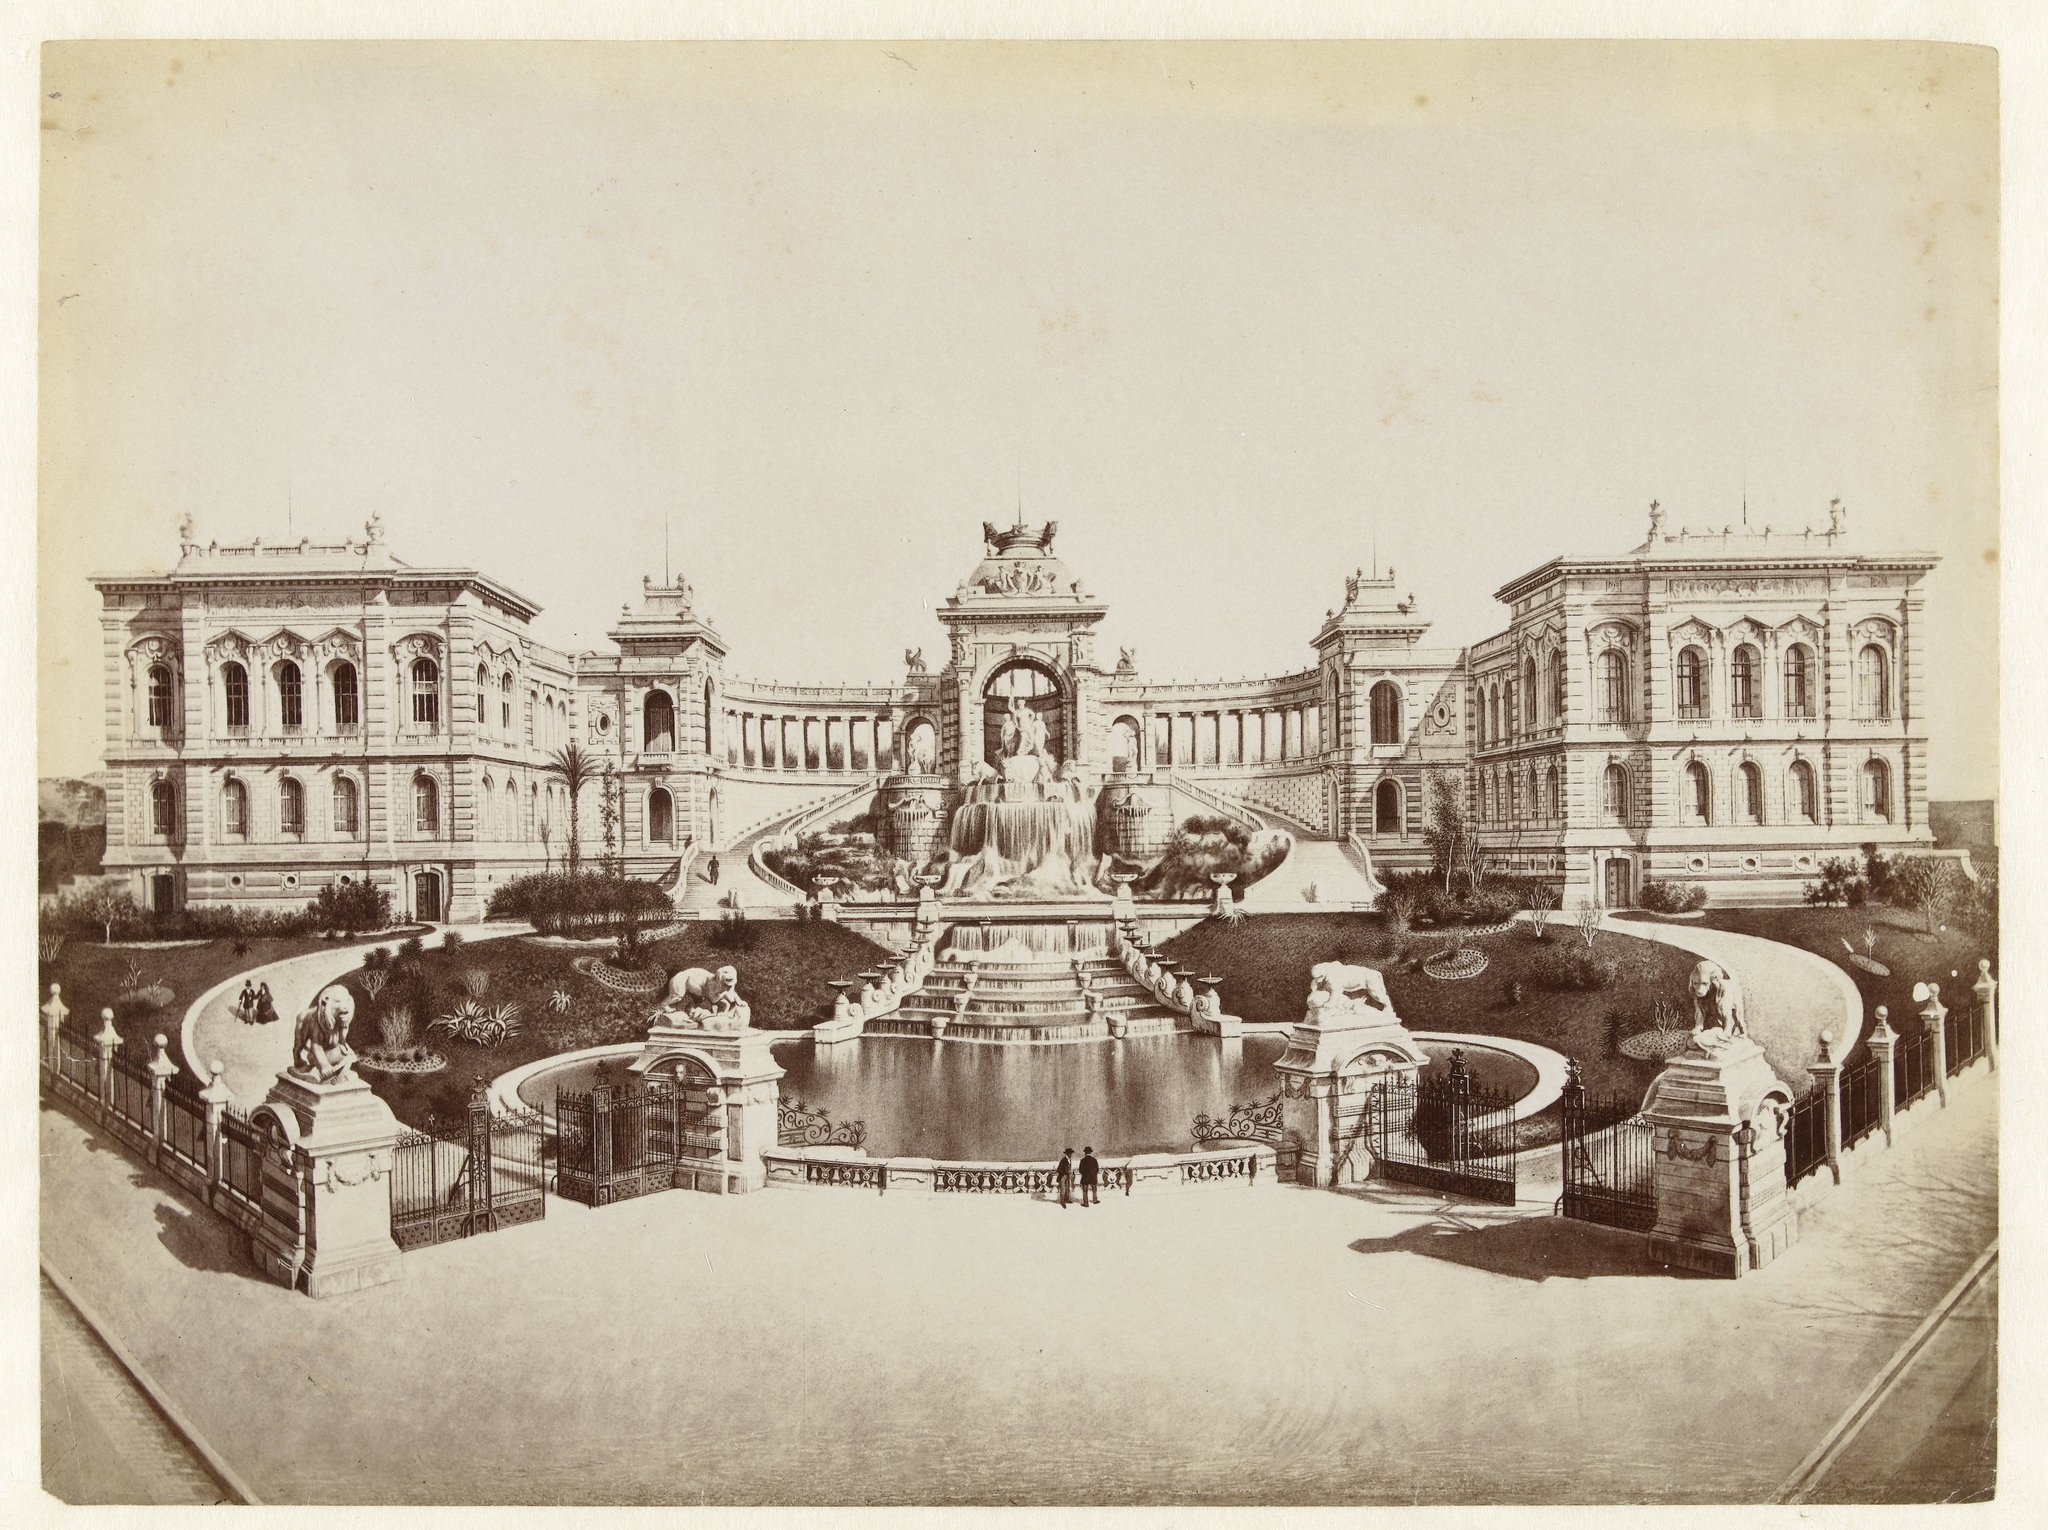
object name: photograph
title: Gezicht op het Palais Longchamp in Marseille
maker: Anonymous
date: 1865-1900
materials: paper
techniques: albumen print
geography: marseille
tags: palace